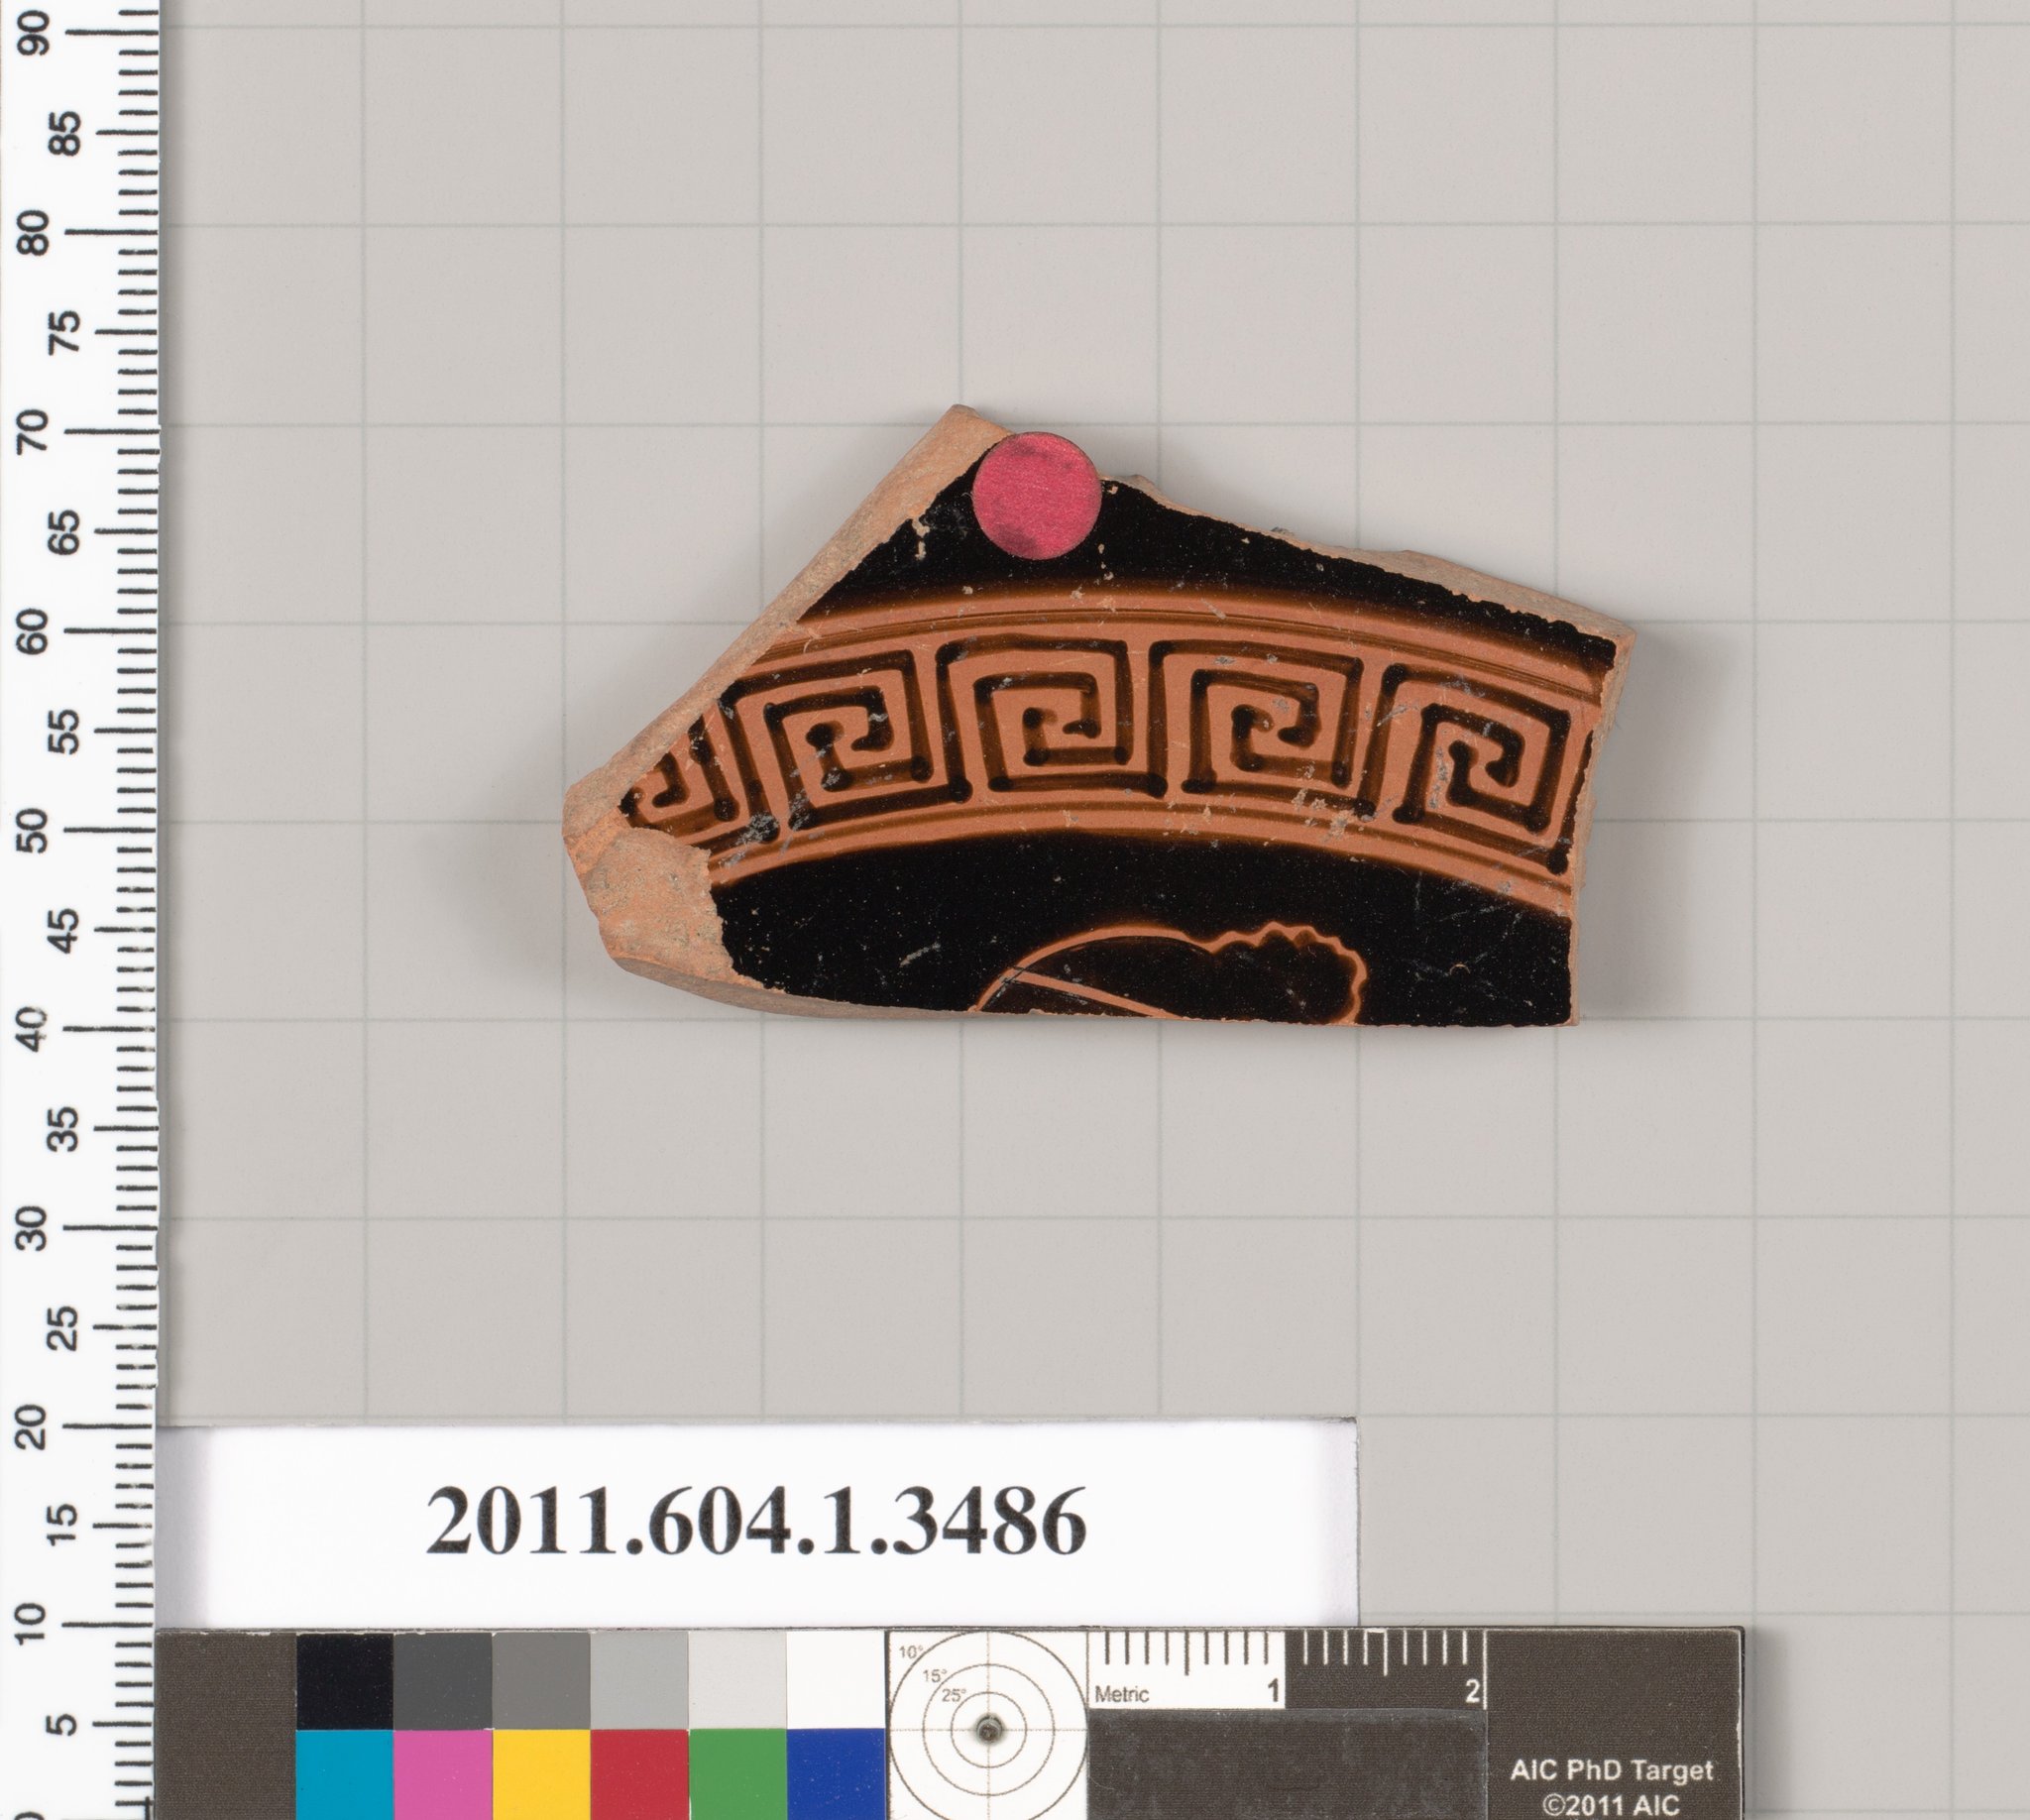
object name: kylix fragment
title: Terracotta fragment of a kylix (drinking cup)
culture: greek, attic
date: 475-460 BCE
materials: terracotta